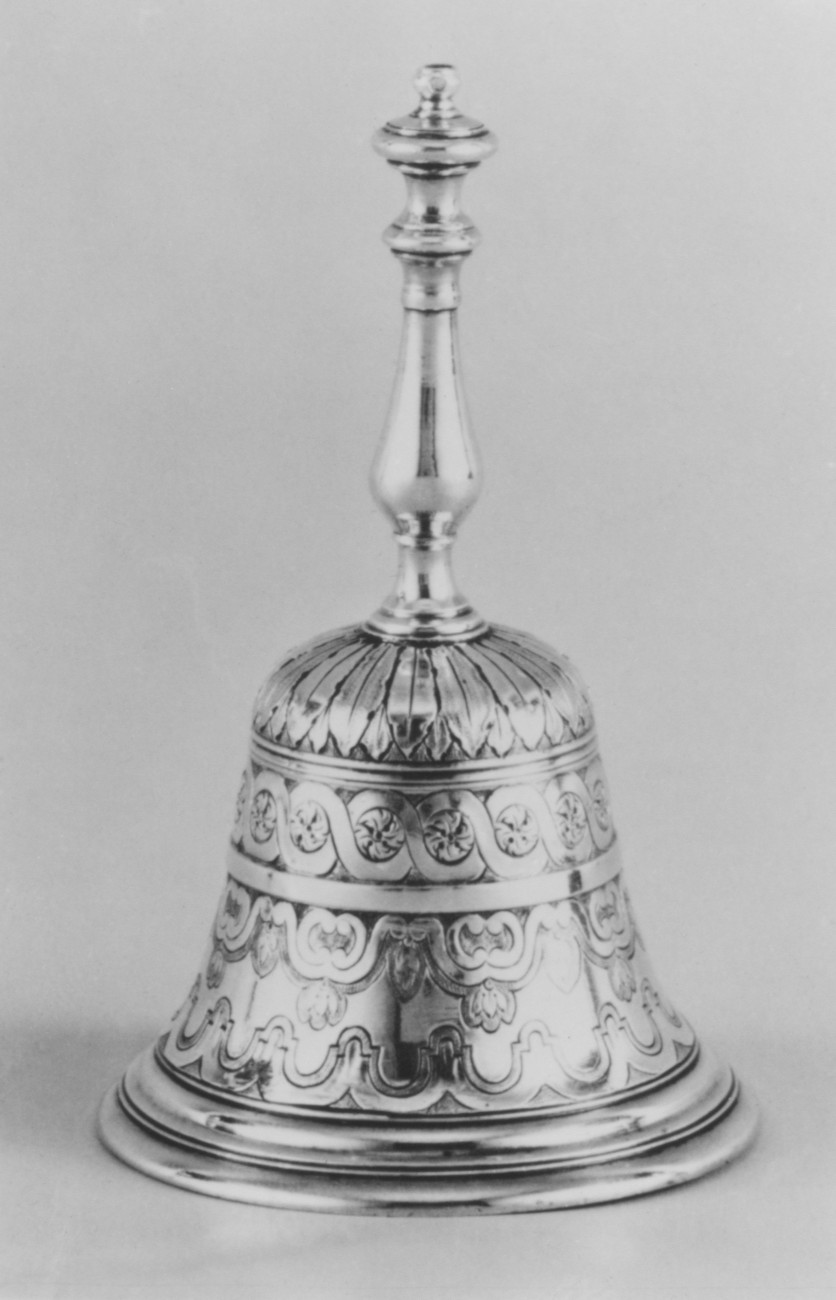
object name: bell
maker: françois delapierre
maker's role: maker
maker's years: 1728-1821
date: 1769-1770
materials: silver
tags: musical instruments